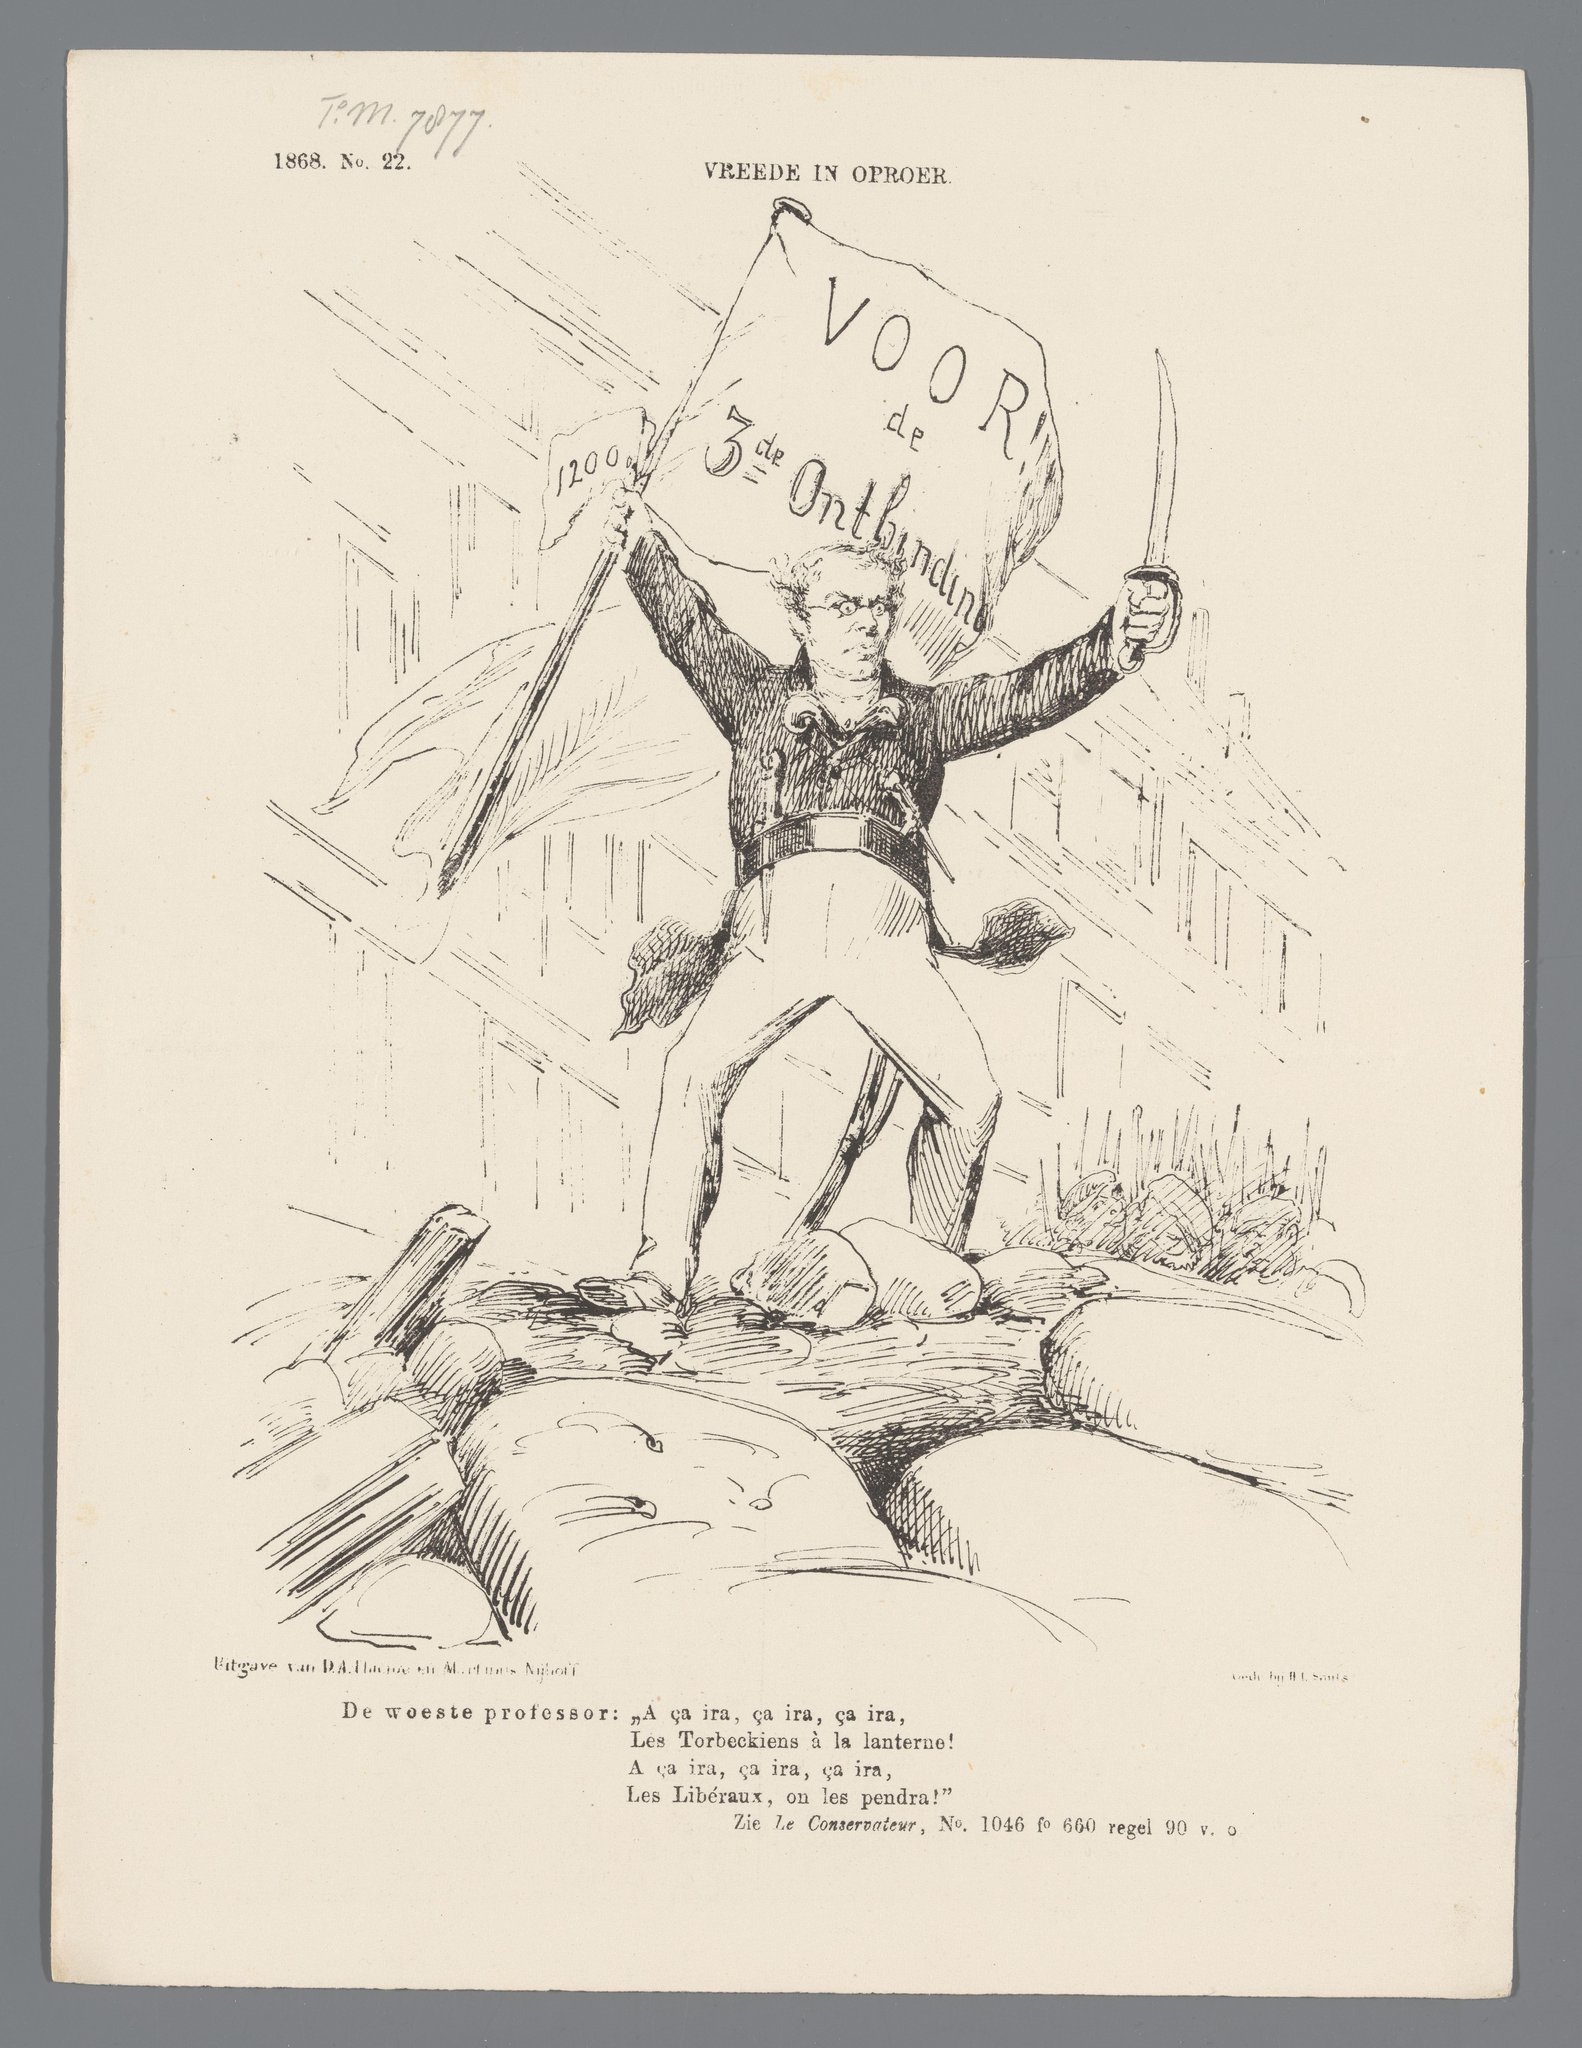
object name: print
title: Spotprent op professor Vreede, 1868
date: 1867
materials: paper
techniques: lithograph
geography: arnhem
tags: utrecht, george willem vreede, barricades ~ riot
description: Spotprent op professor George Willem Vreede en zijn oproep om de Tweede Kamer te ontbinden. De professor als een woeste opstandeling staande met vlag en sabel op de barricade. Plaat verschenen bij het weekblad De Nederlandsche Spectator, nr. 22, 30 mei 1868.